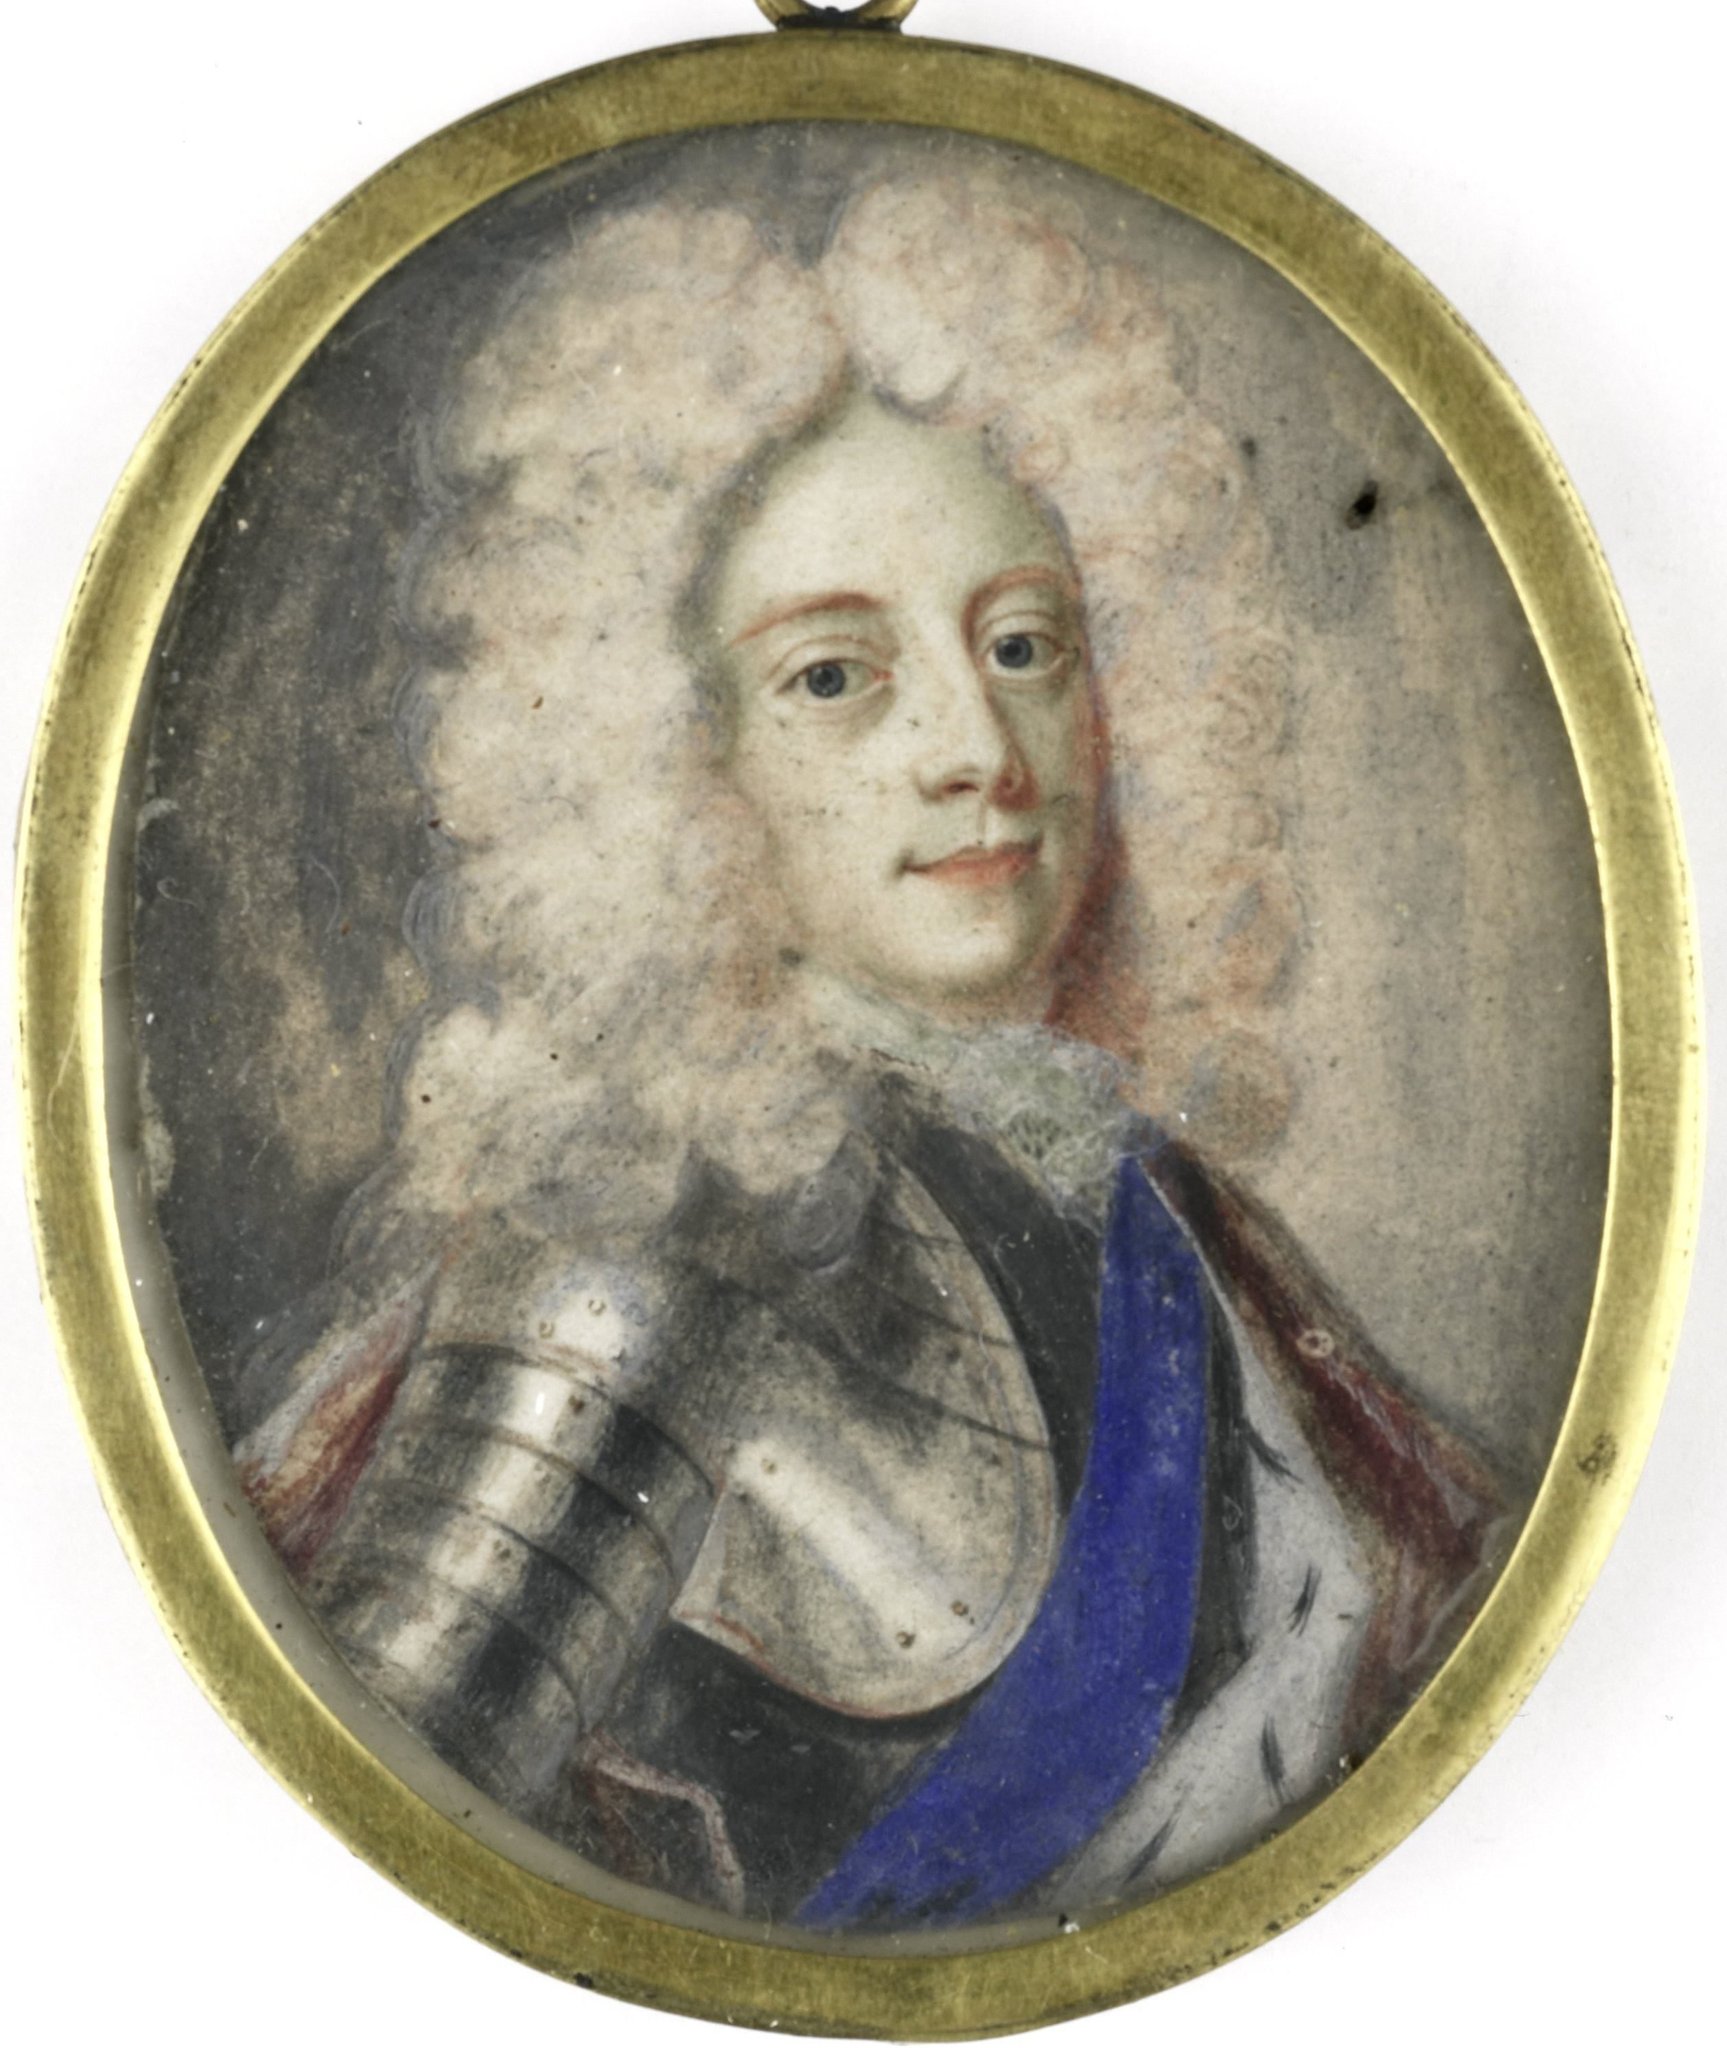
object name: painting, miniature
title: Portrait of George II (1683-1760), King of England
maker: benjamin arlaud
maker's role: miniatuurschilder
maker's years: 1670-1731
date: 1706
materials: cardboard, glass, metal, watercolor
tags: hannover, koning, george ii (koning van groot-brittannië)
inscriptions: signature and date: ‘Benjamin Arlaud pinxit 1706’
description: Portret van George II (1683-1760), koning van Engeland. Buste naar rechts, aanziend, in wapenrusting. Vroeger beschouwd als een portret van Christiaan V (1646-99), koning van Denemarken. Onderdeel van de collectie portretminiaturen.